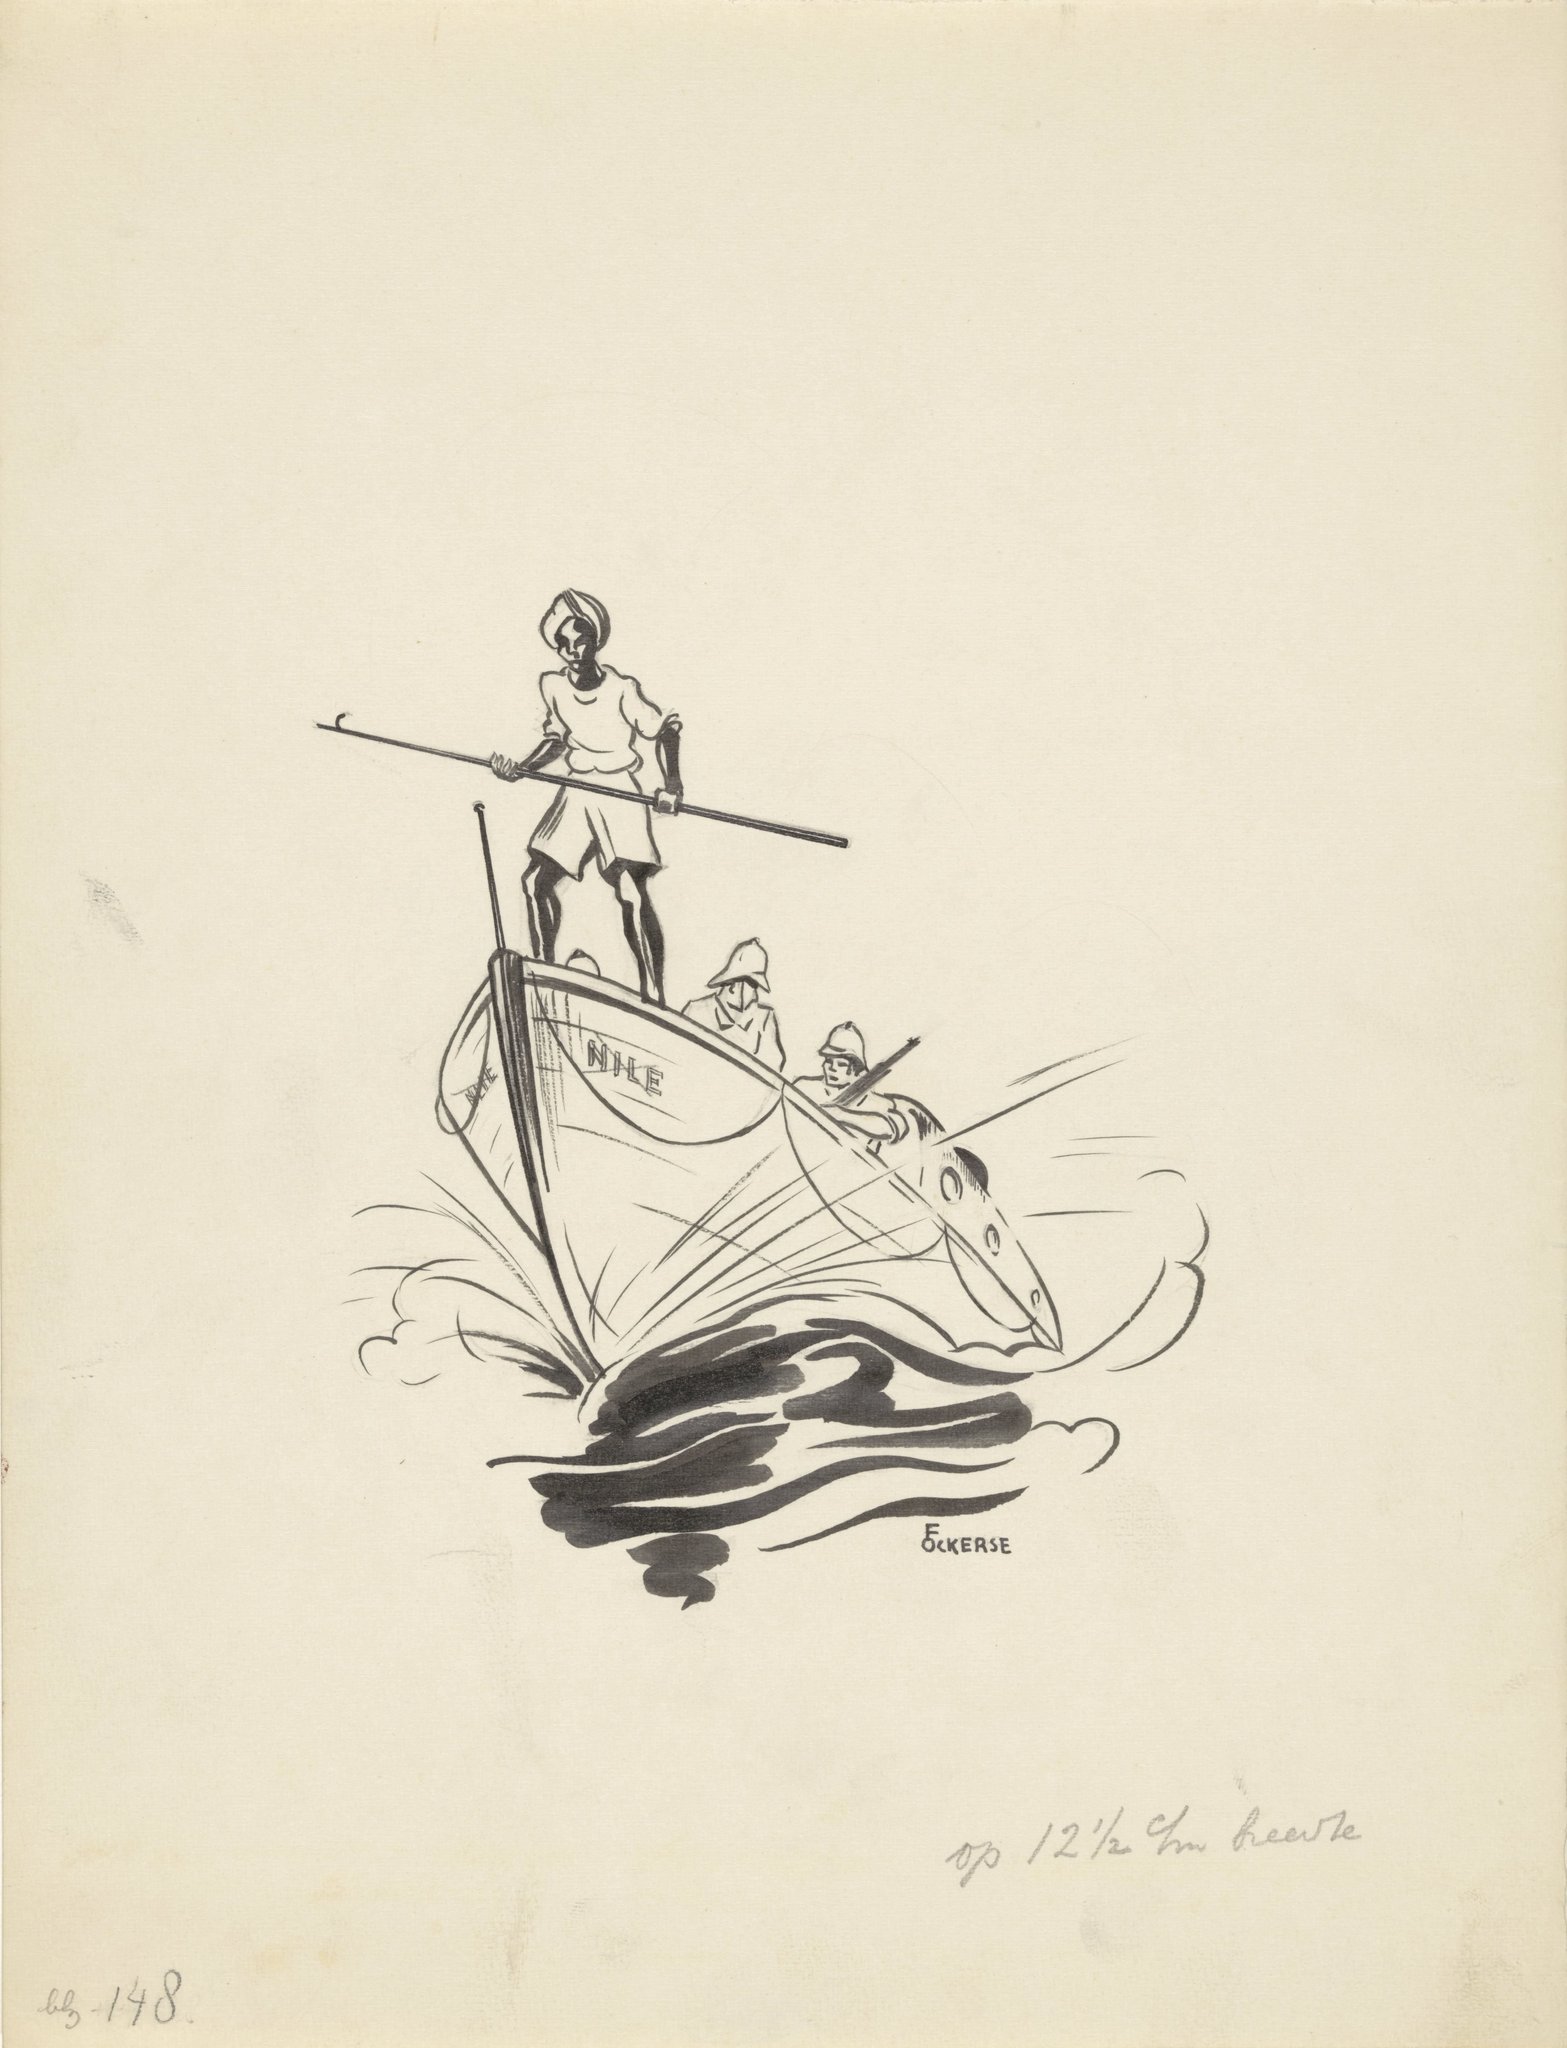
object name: boekillustratie ontwerp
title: Drie mannen op een boot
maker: f. ockerse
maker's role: draughtsman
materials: paint, paper, pencil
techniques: brush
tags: ships (in general), firearms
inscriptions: collector's mark: Lugt 2228, :, annotation: ‘blz. 148.’, signature: ‘F/ OCKERSE’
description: Een boot genaamd 'Nile' vaart met grote snelheid over het water. Op het dek staat een man met een tulband. Hij heeft een stok in zijn handen. Achter hem zitten twee mannen met helmen. Eén van hen draagt een geweer.